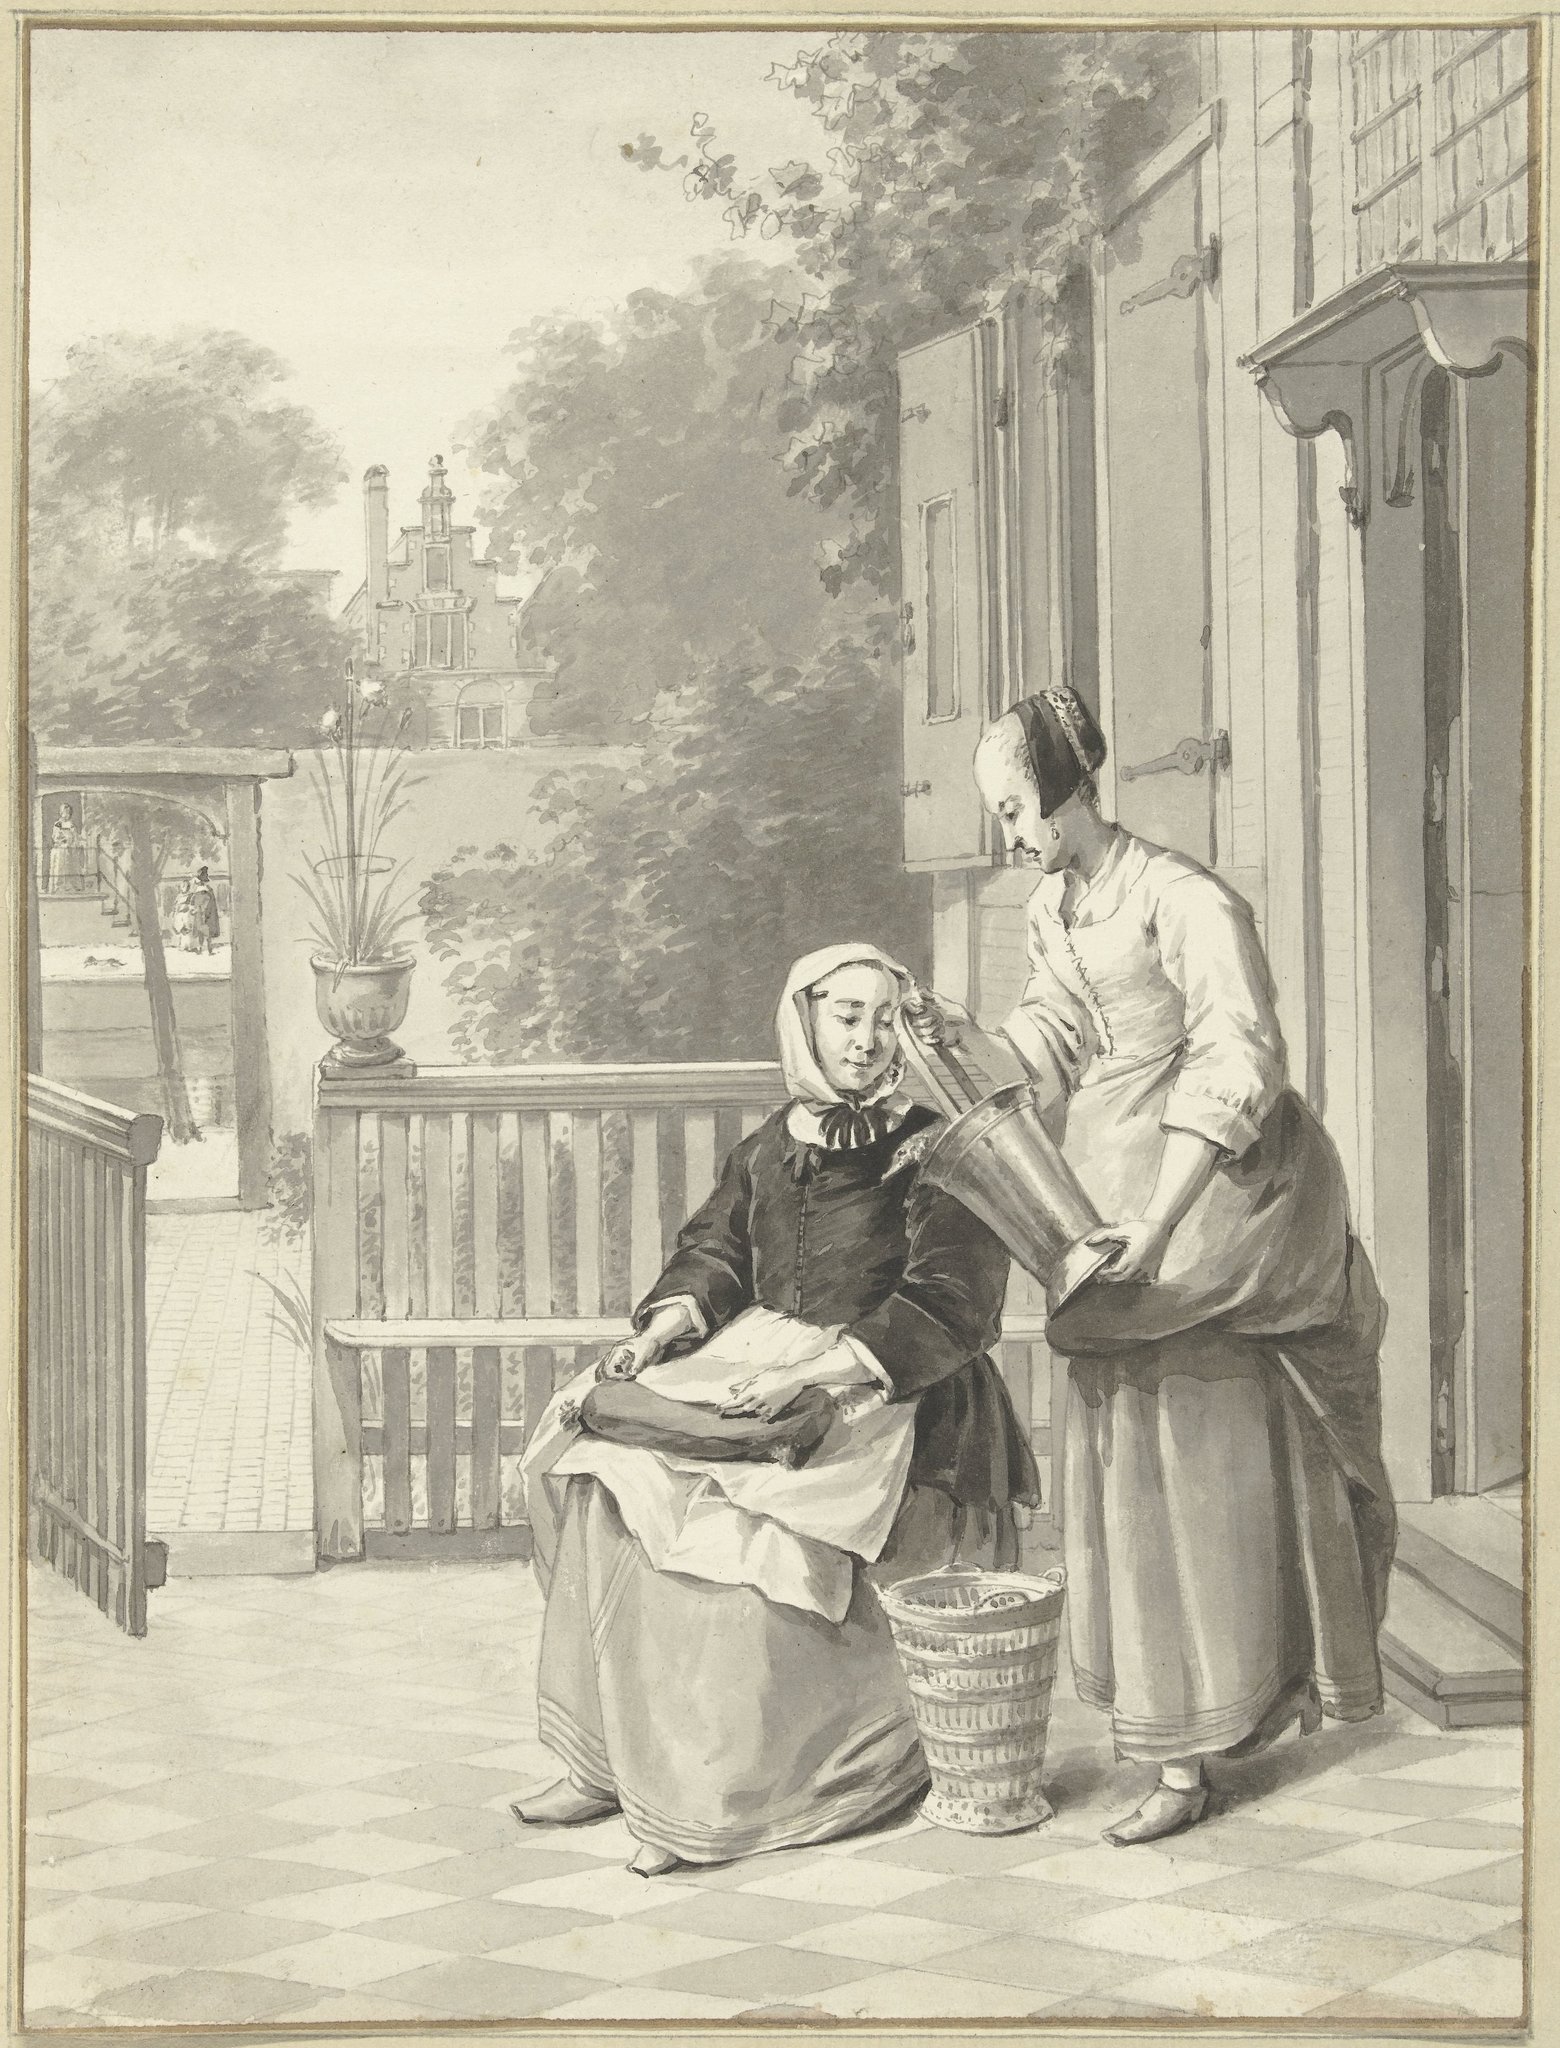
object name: drawing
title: Dame met keukenmeid voor een huis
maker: wybrand hendriks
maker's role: draughtsman, painter, print maker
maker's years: 1744-1831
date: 1754-1831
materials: ink, paper, pencil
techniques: brush, pen